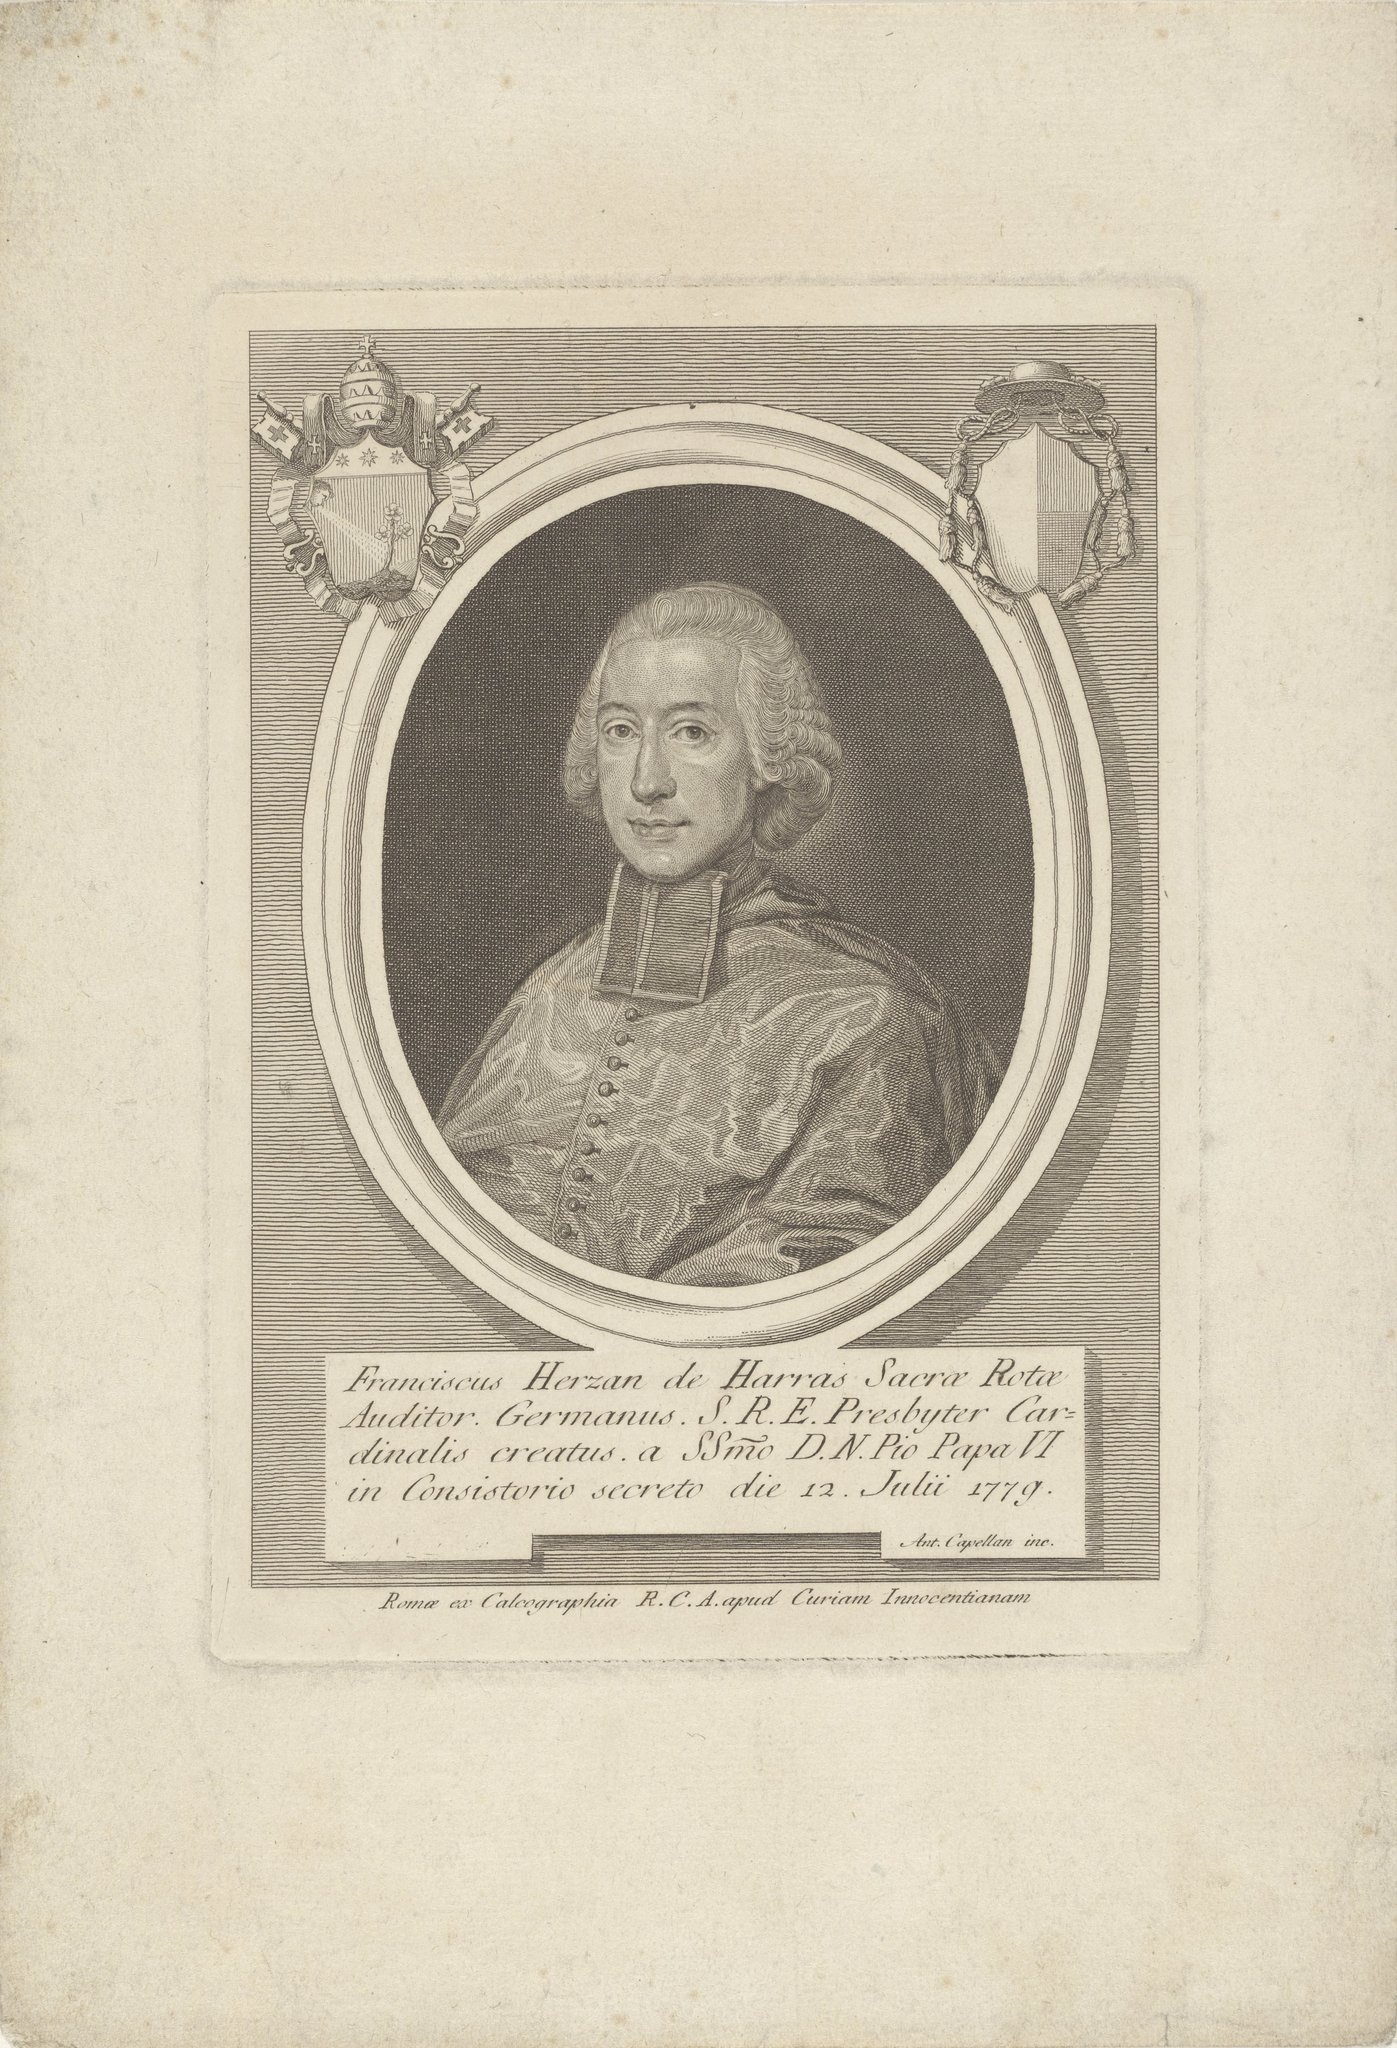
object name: print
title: Effigies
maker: antonio capellan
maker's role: print maker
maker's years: 1735-1788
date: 1779-1788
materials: paper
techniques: etching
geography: rome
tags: prague, vienna, cardinal, historical persons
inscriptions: collector's mark: Lugt 2228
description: Prent uit een reeks van onbekende omvang met portretten van kardinalen. De prenten werden vanaf 1657 vervaardigd in opdracht van uitgever Giovanni Giacomo de’ Rossi, waarna de productie werd voortgezet onder leiding van zijn opvolgers Domenico de’ Rossi en Lorenzo Filippo de’ Rossi, en tenslotte onder leiding van de Calcographia R.C.A.